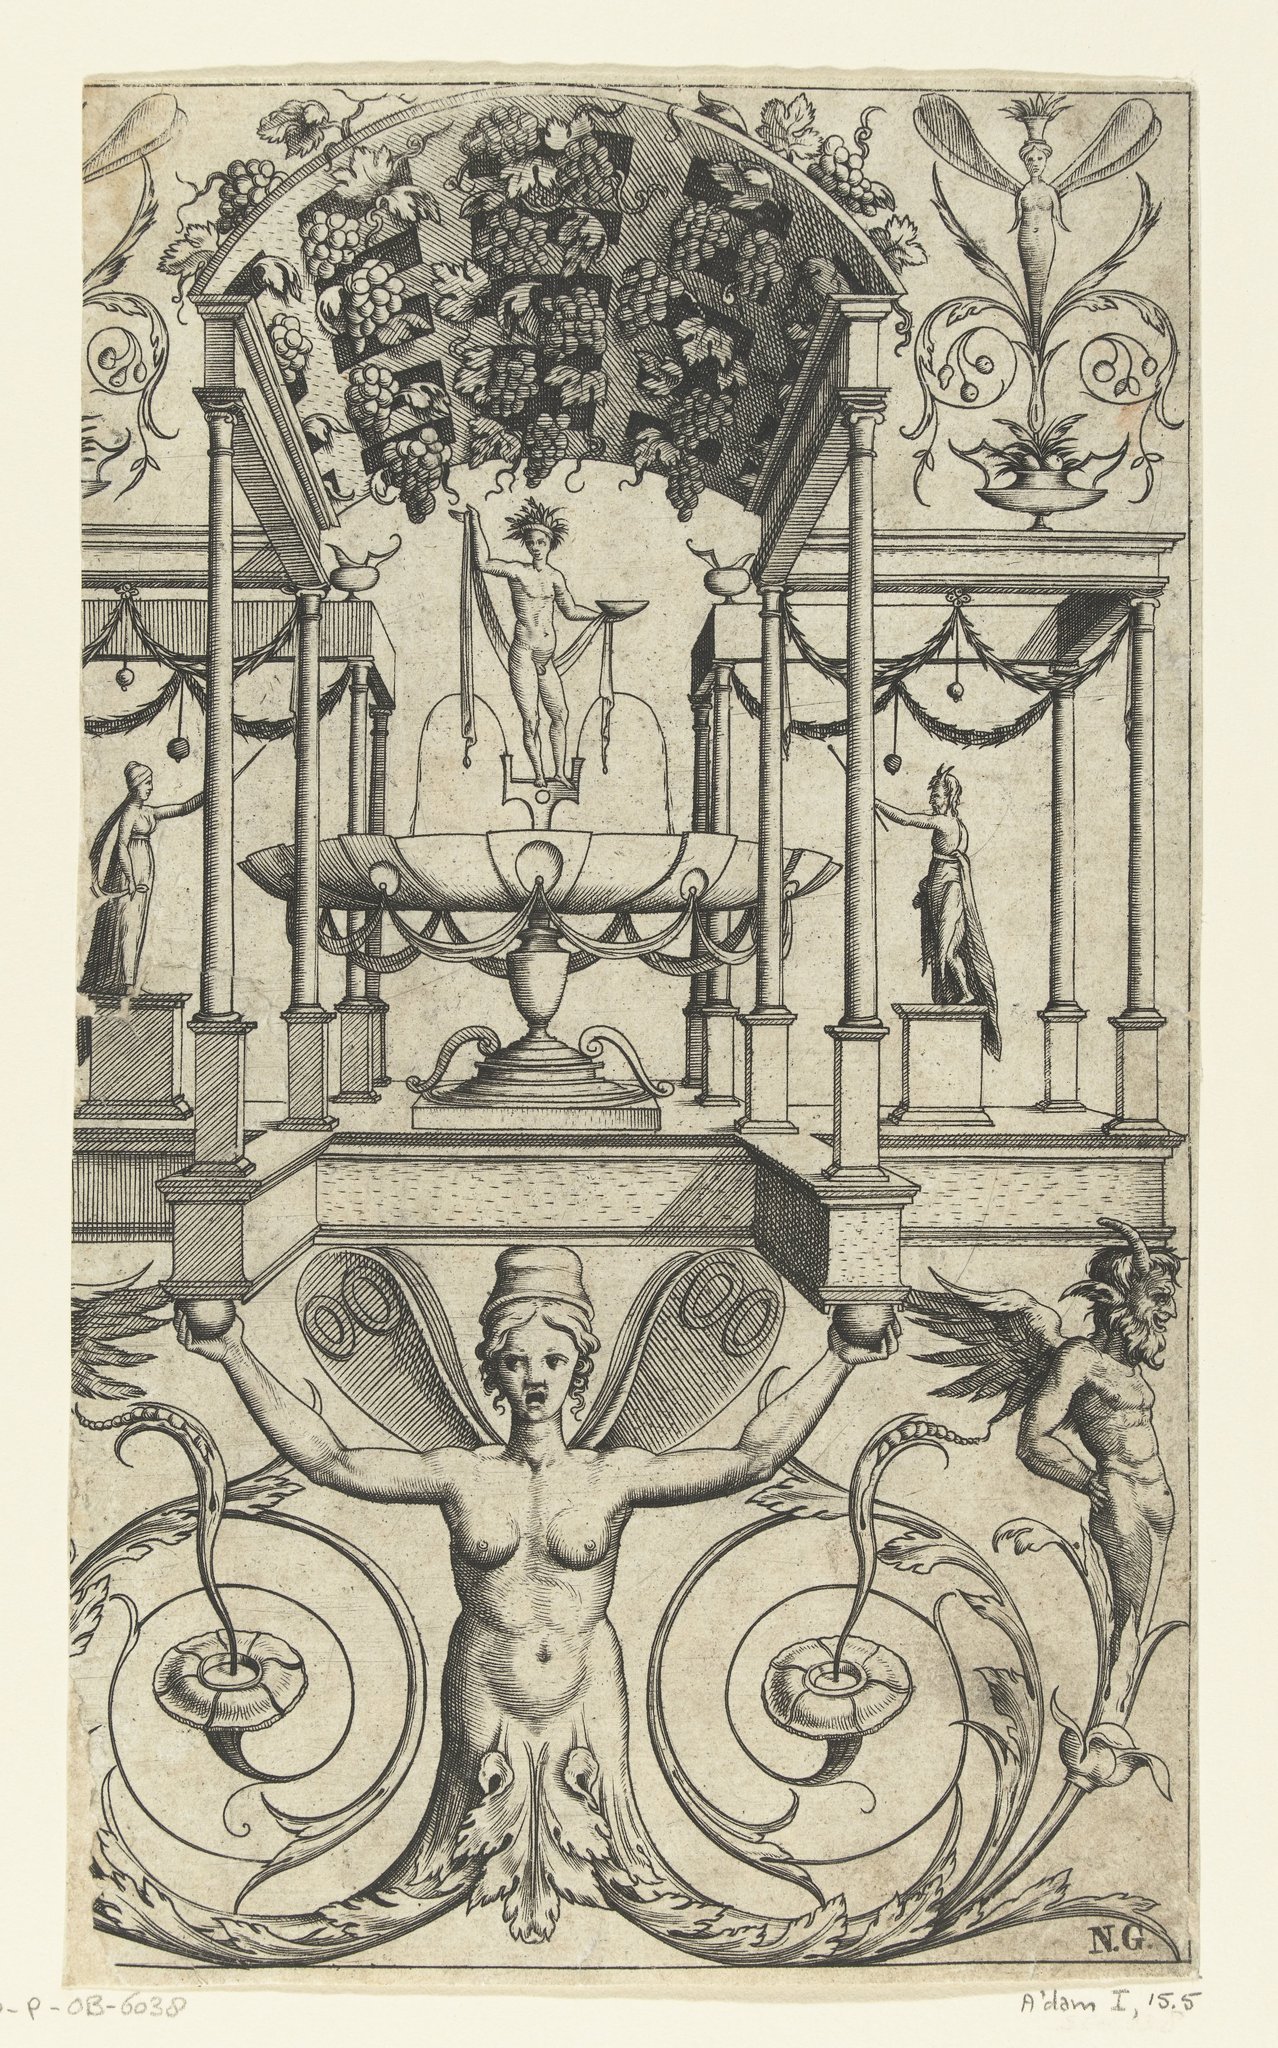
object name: ornament print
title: Groteske vlakdecoraties met kandelabers, mythologische figuren, fabelwezens, bladranken en trofeeën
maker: Anonymous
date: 1516-1556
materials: paper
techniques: engraving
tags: ornament ~ grotesque, ornament ~ hybrid beings; human and animal forms mixed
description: In het middengedeelte van het prieel, dat door een met druiventrossen gedecoreerd cassettenplafond overdekt is, staat een fontein. Blad uit serie van 9 bladen.